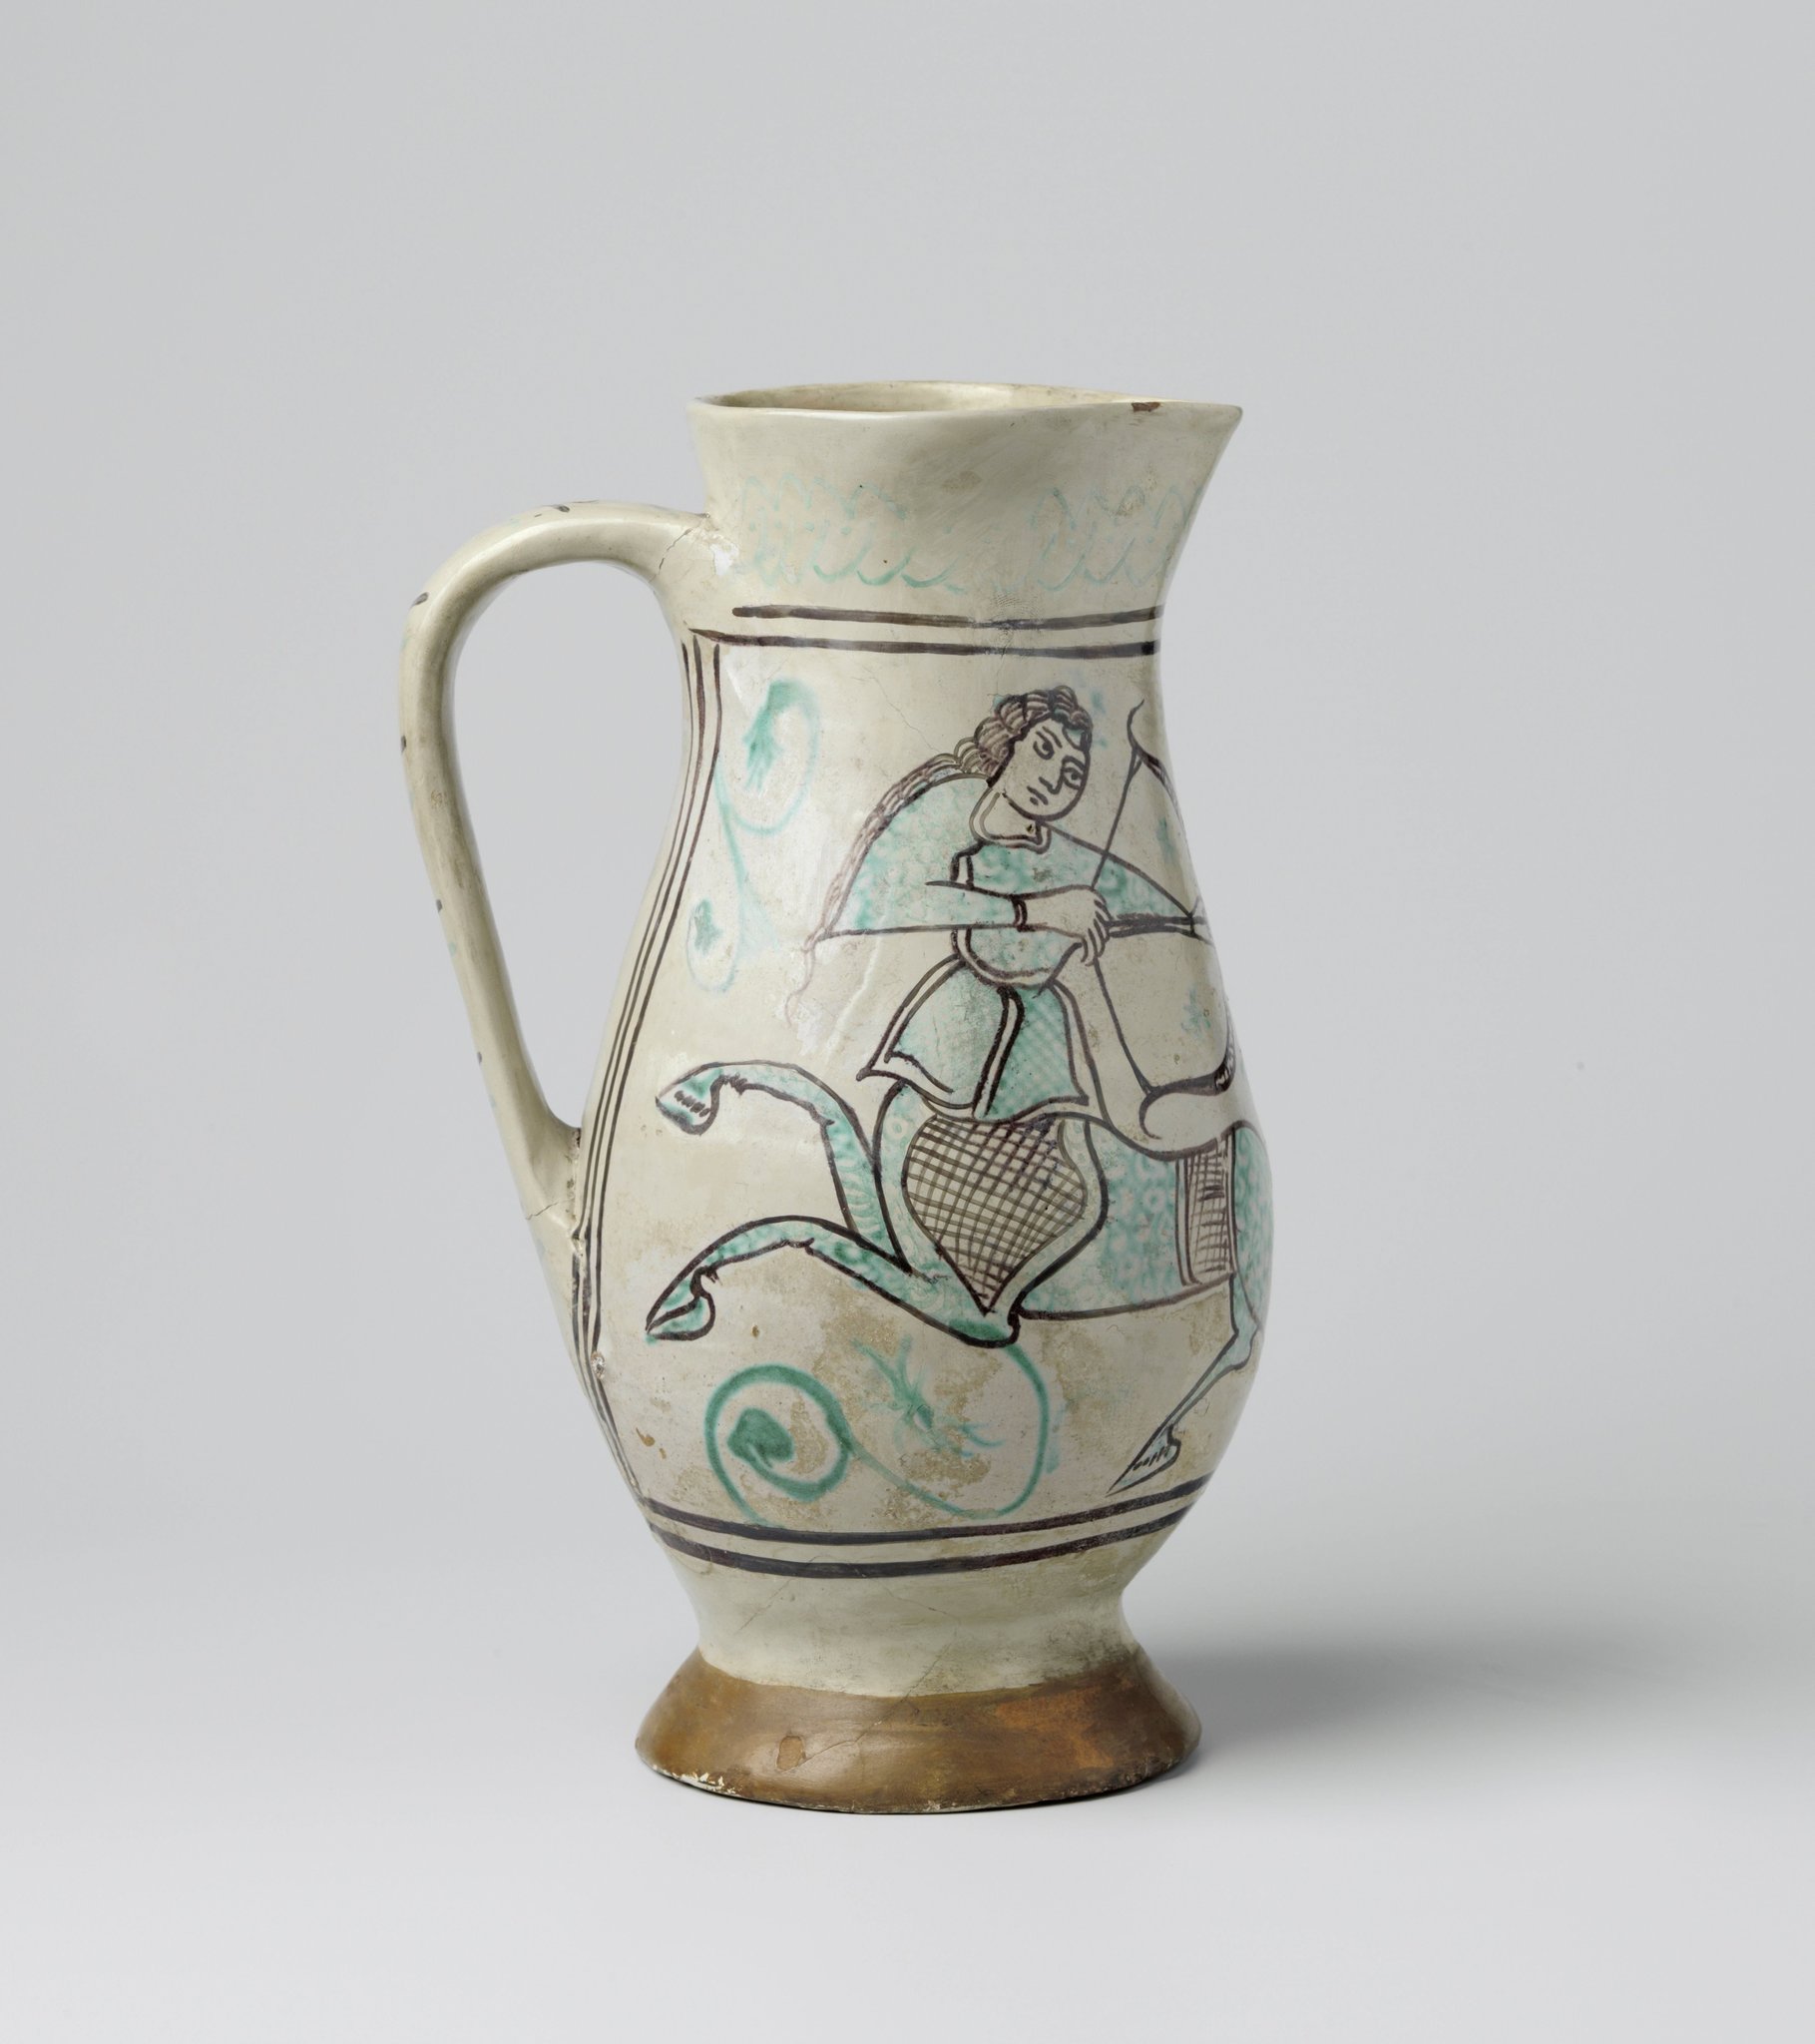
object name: ewer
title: Kan, omgekeerd balustervormig, met oor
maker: Anonymous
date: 1400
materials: earthenware, glaze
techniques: maiolica, painted, polychromy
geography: orvieto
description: Maiolica Jug with a female centaur shooting an arrow. Central Italy, c. 1400. J.W. Edwin vom Rath bequest, 1941.